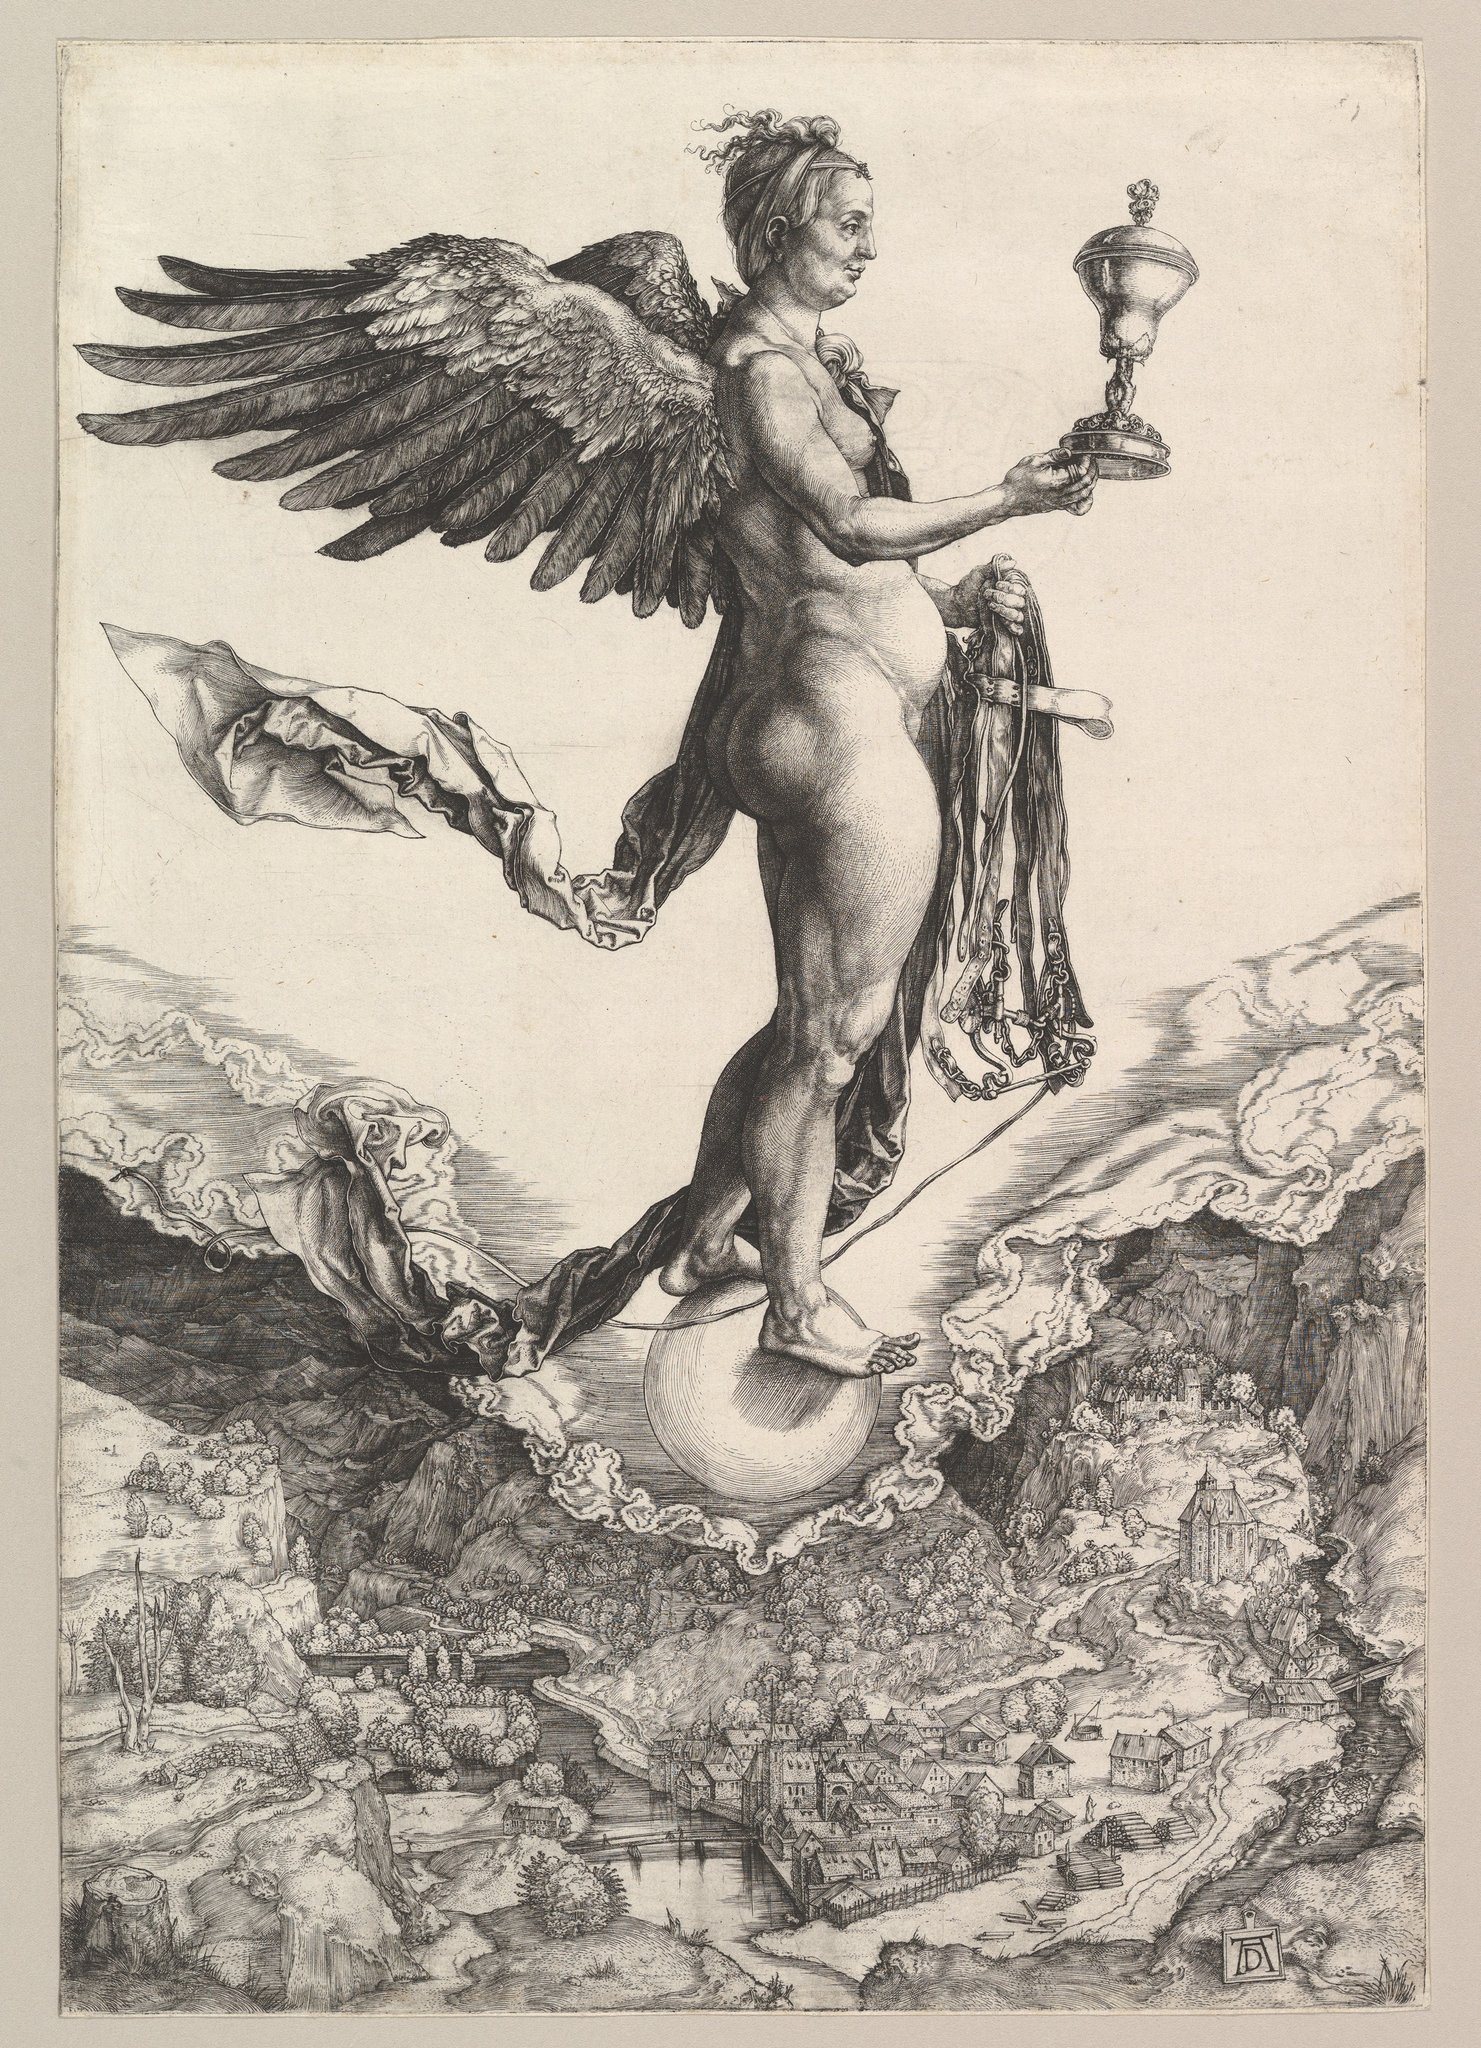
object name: print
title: Nemesis (The Great Fortune)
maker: albrecht dürer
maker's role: artist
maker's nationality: german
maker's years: 1471-1528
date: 1501-1502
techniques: engraving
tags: female nudes